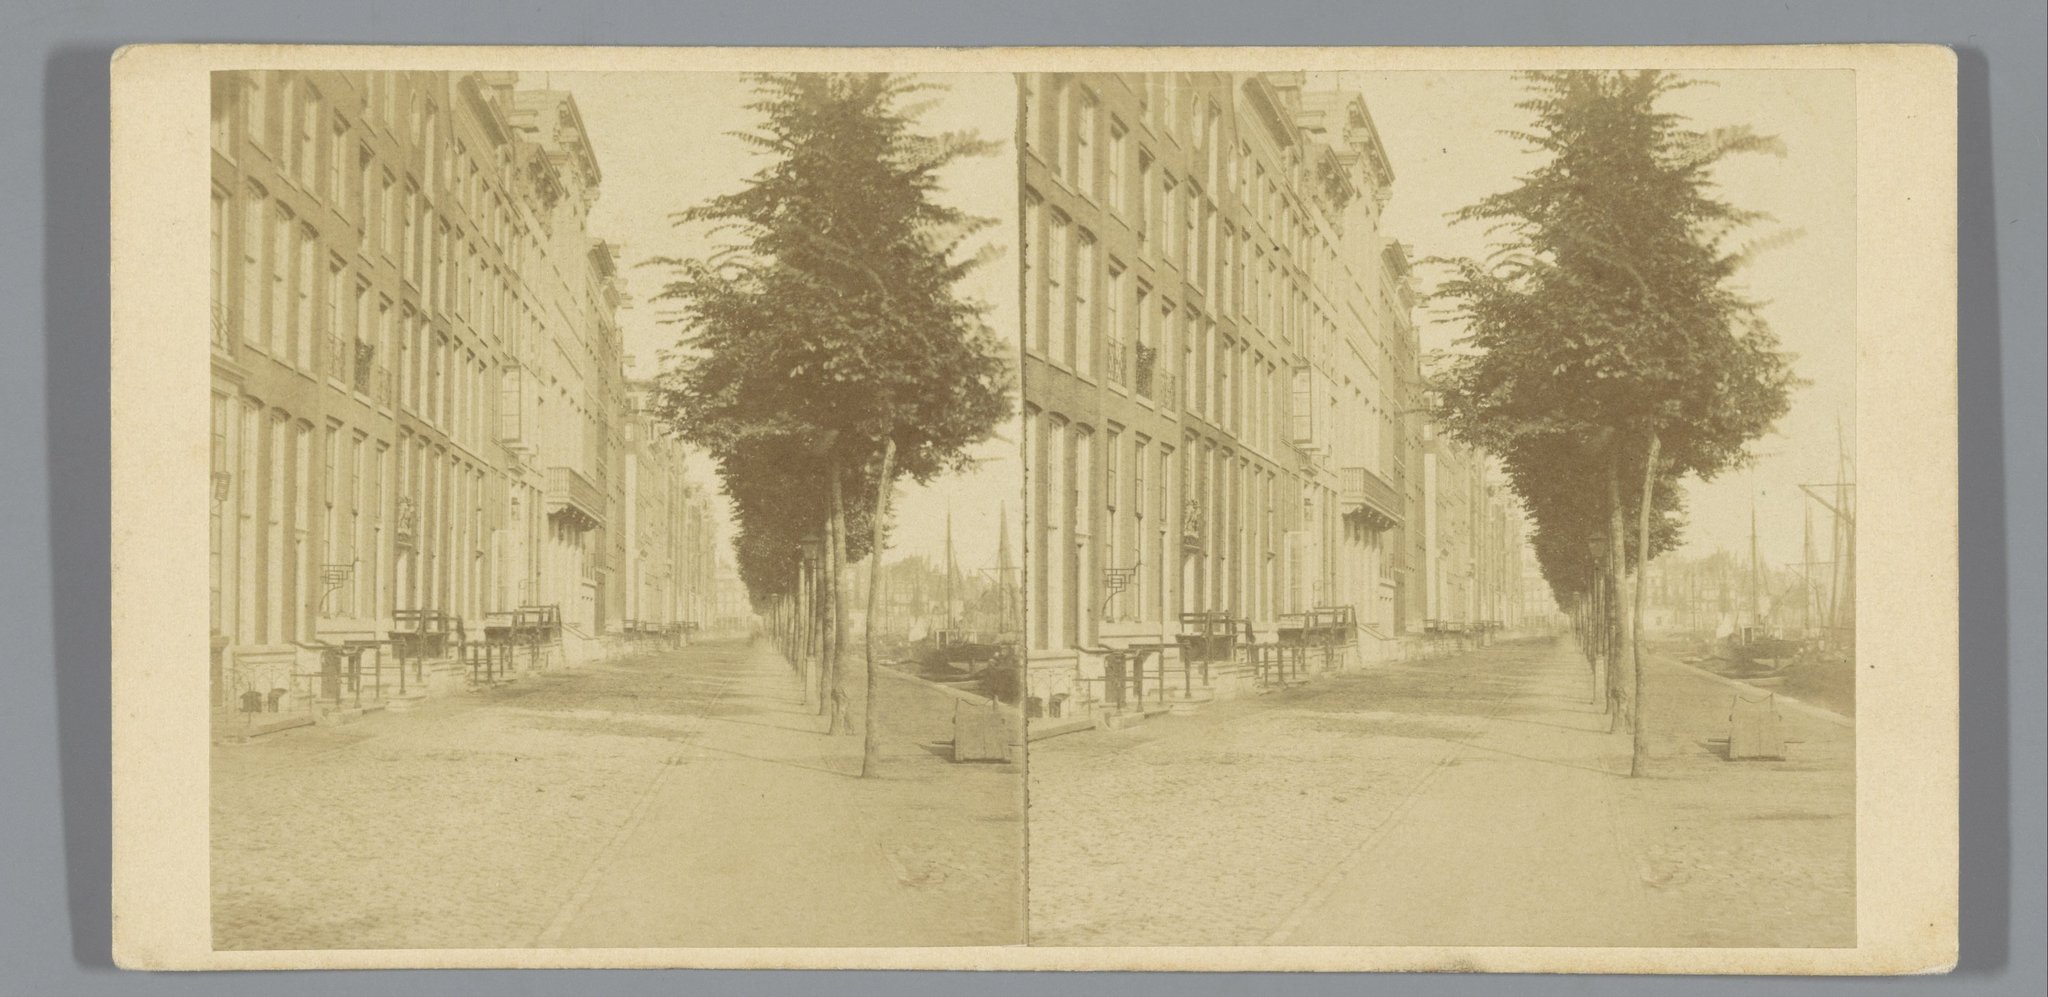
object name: stereograph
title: Vues de Hollande, Amsterdam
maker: pieter oosterhuis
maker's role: draughtsman, print maker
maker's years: 1816-1885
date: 1859-1870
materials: cardboard, paper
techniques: albumen print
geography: amsterdam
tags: street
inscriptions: number: ‘262’